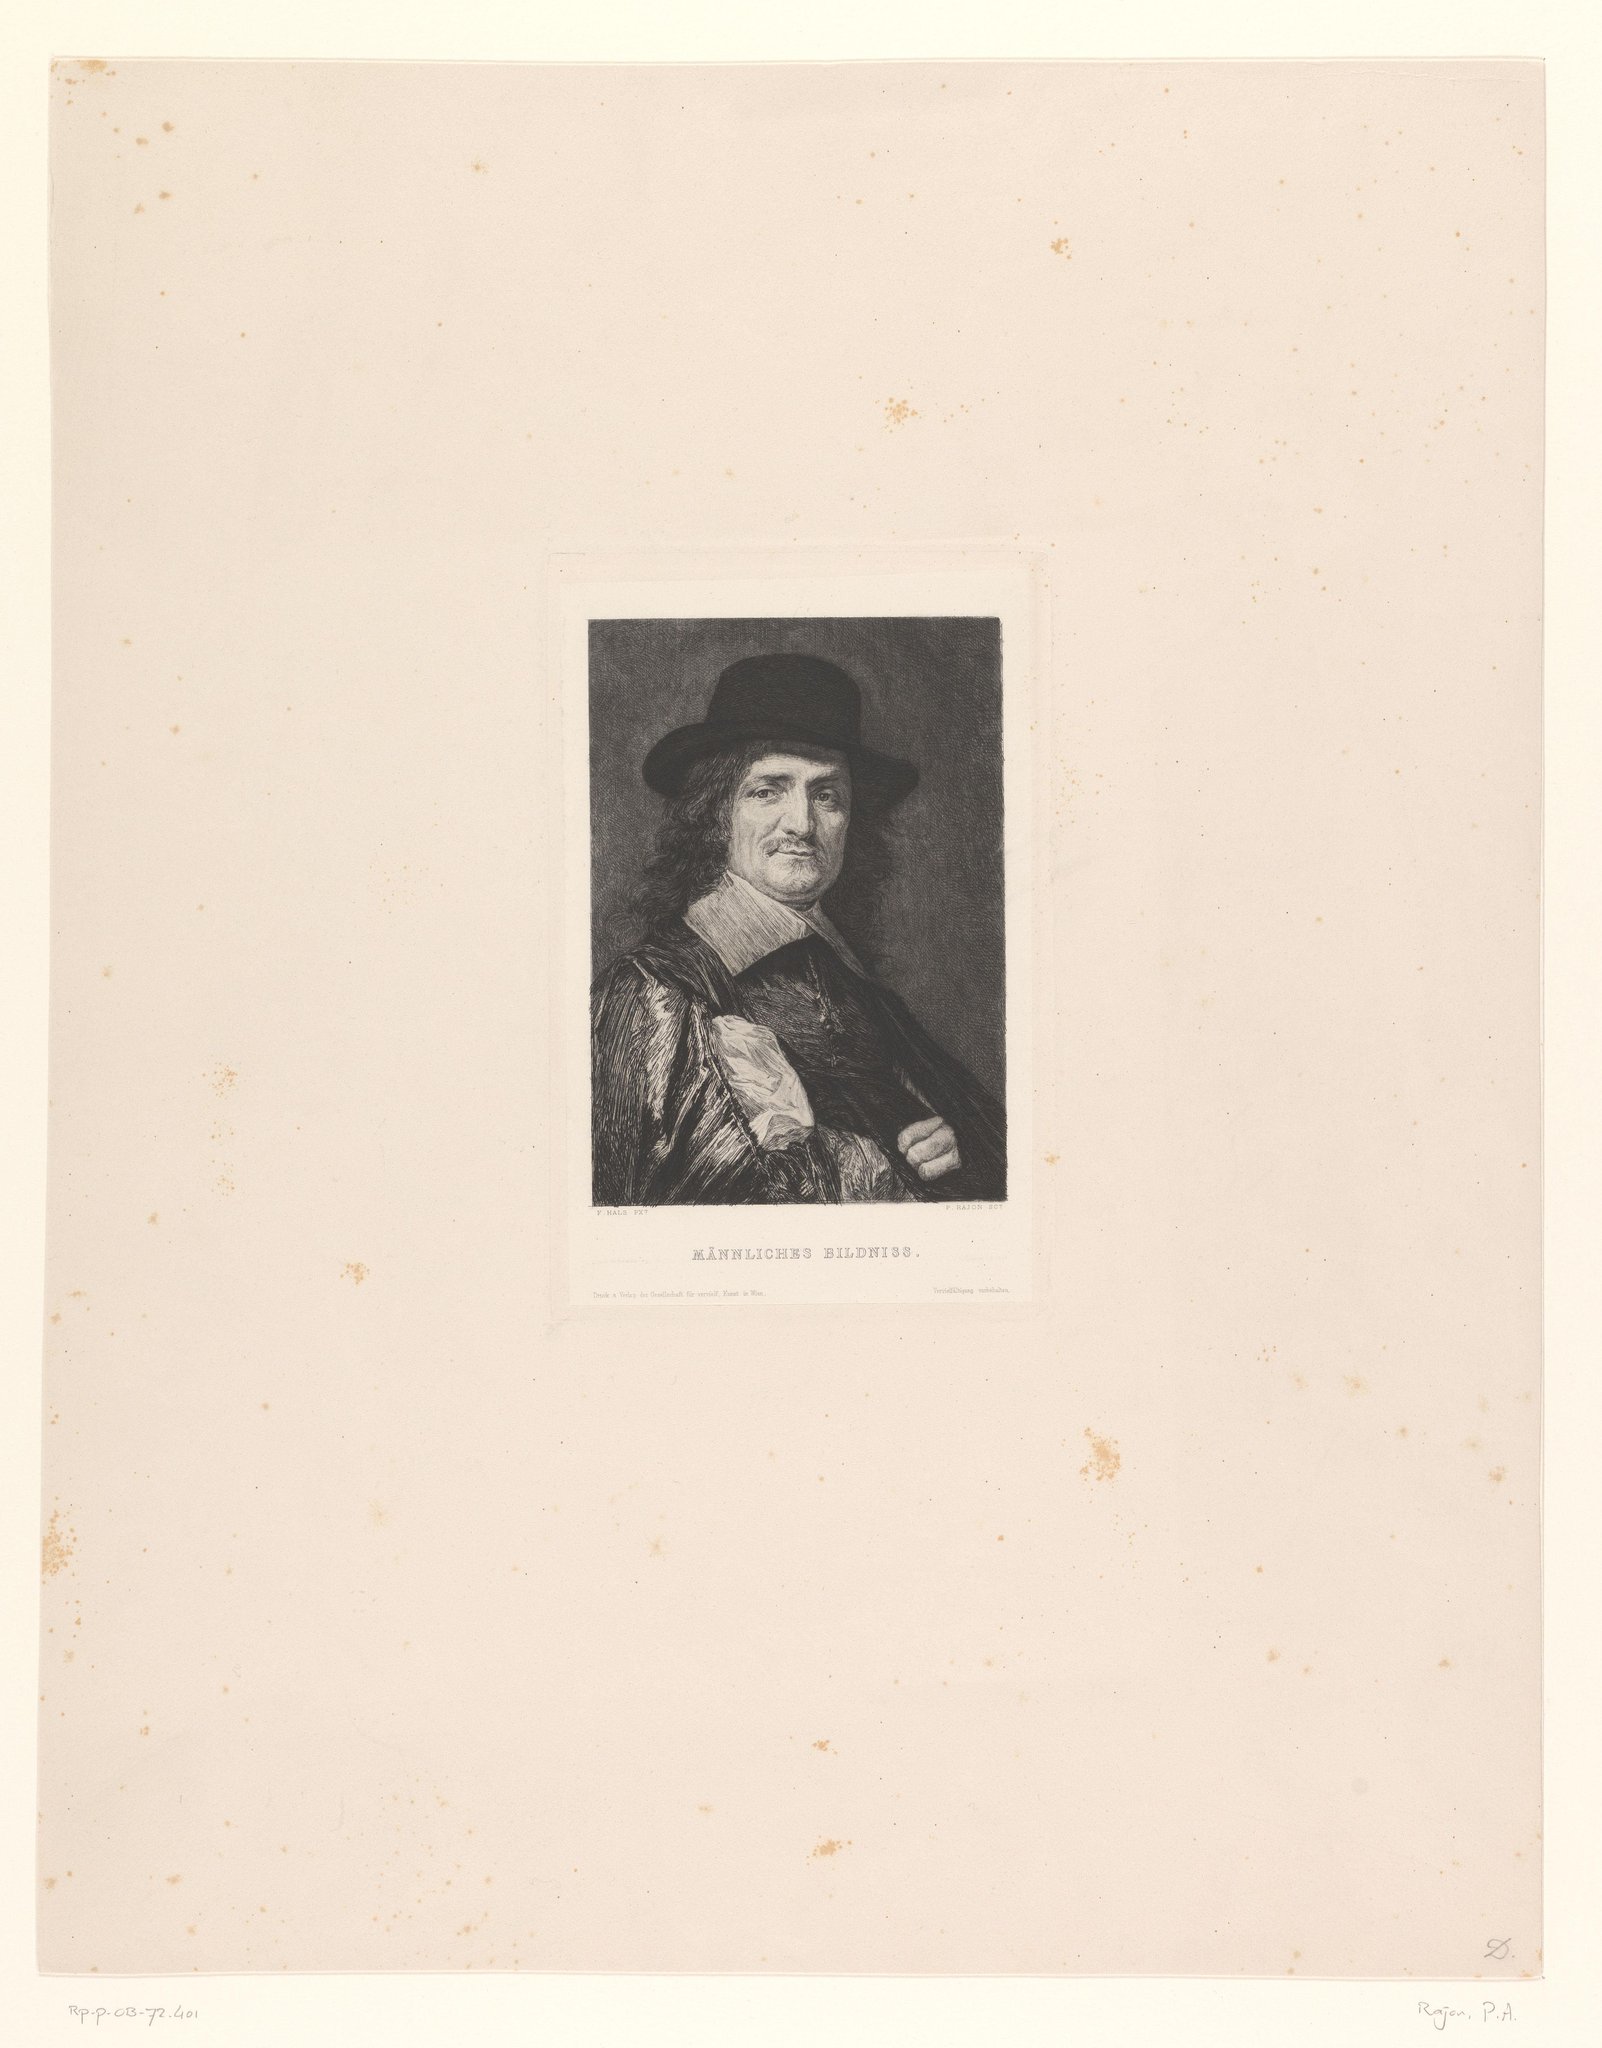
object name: print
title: Man met hoed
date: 1852-1888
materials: paper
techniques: etching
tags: adult man